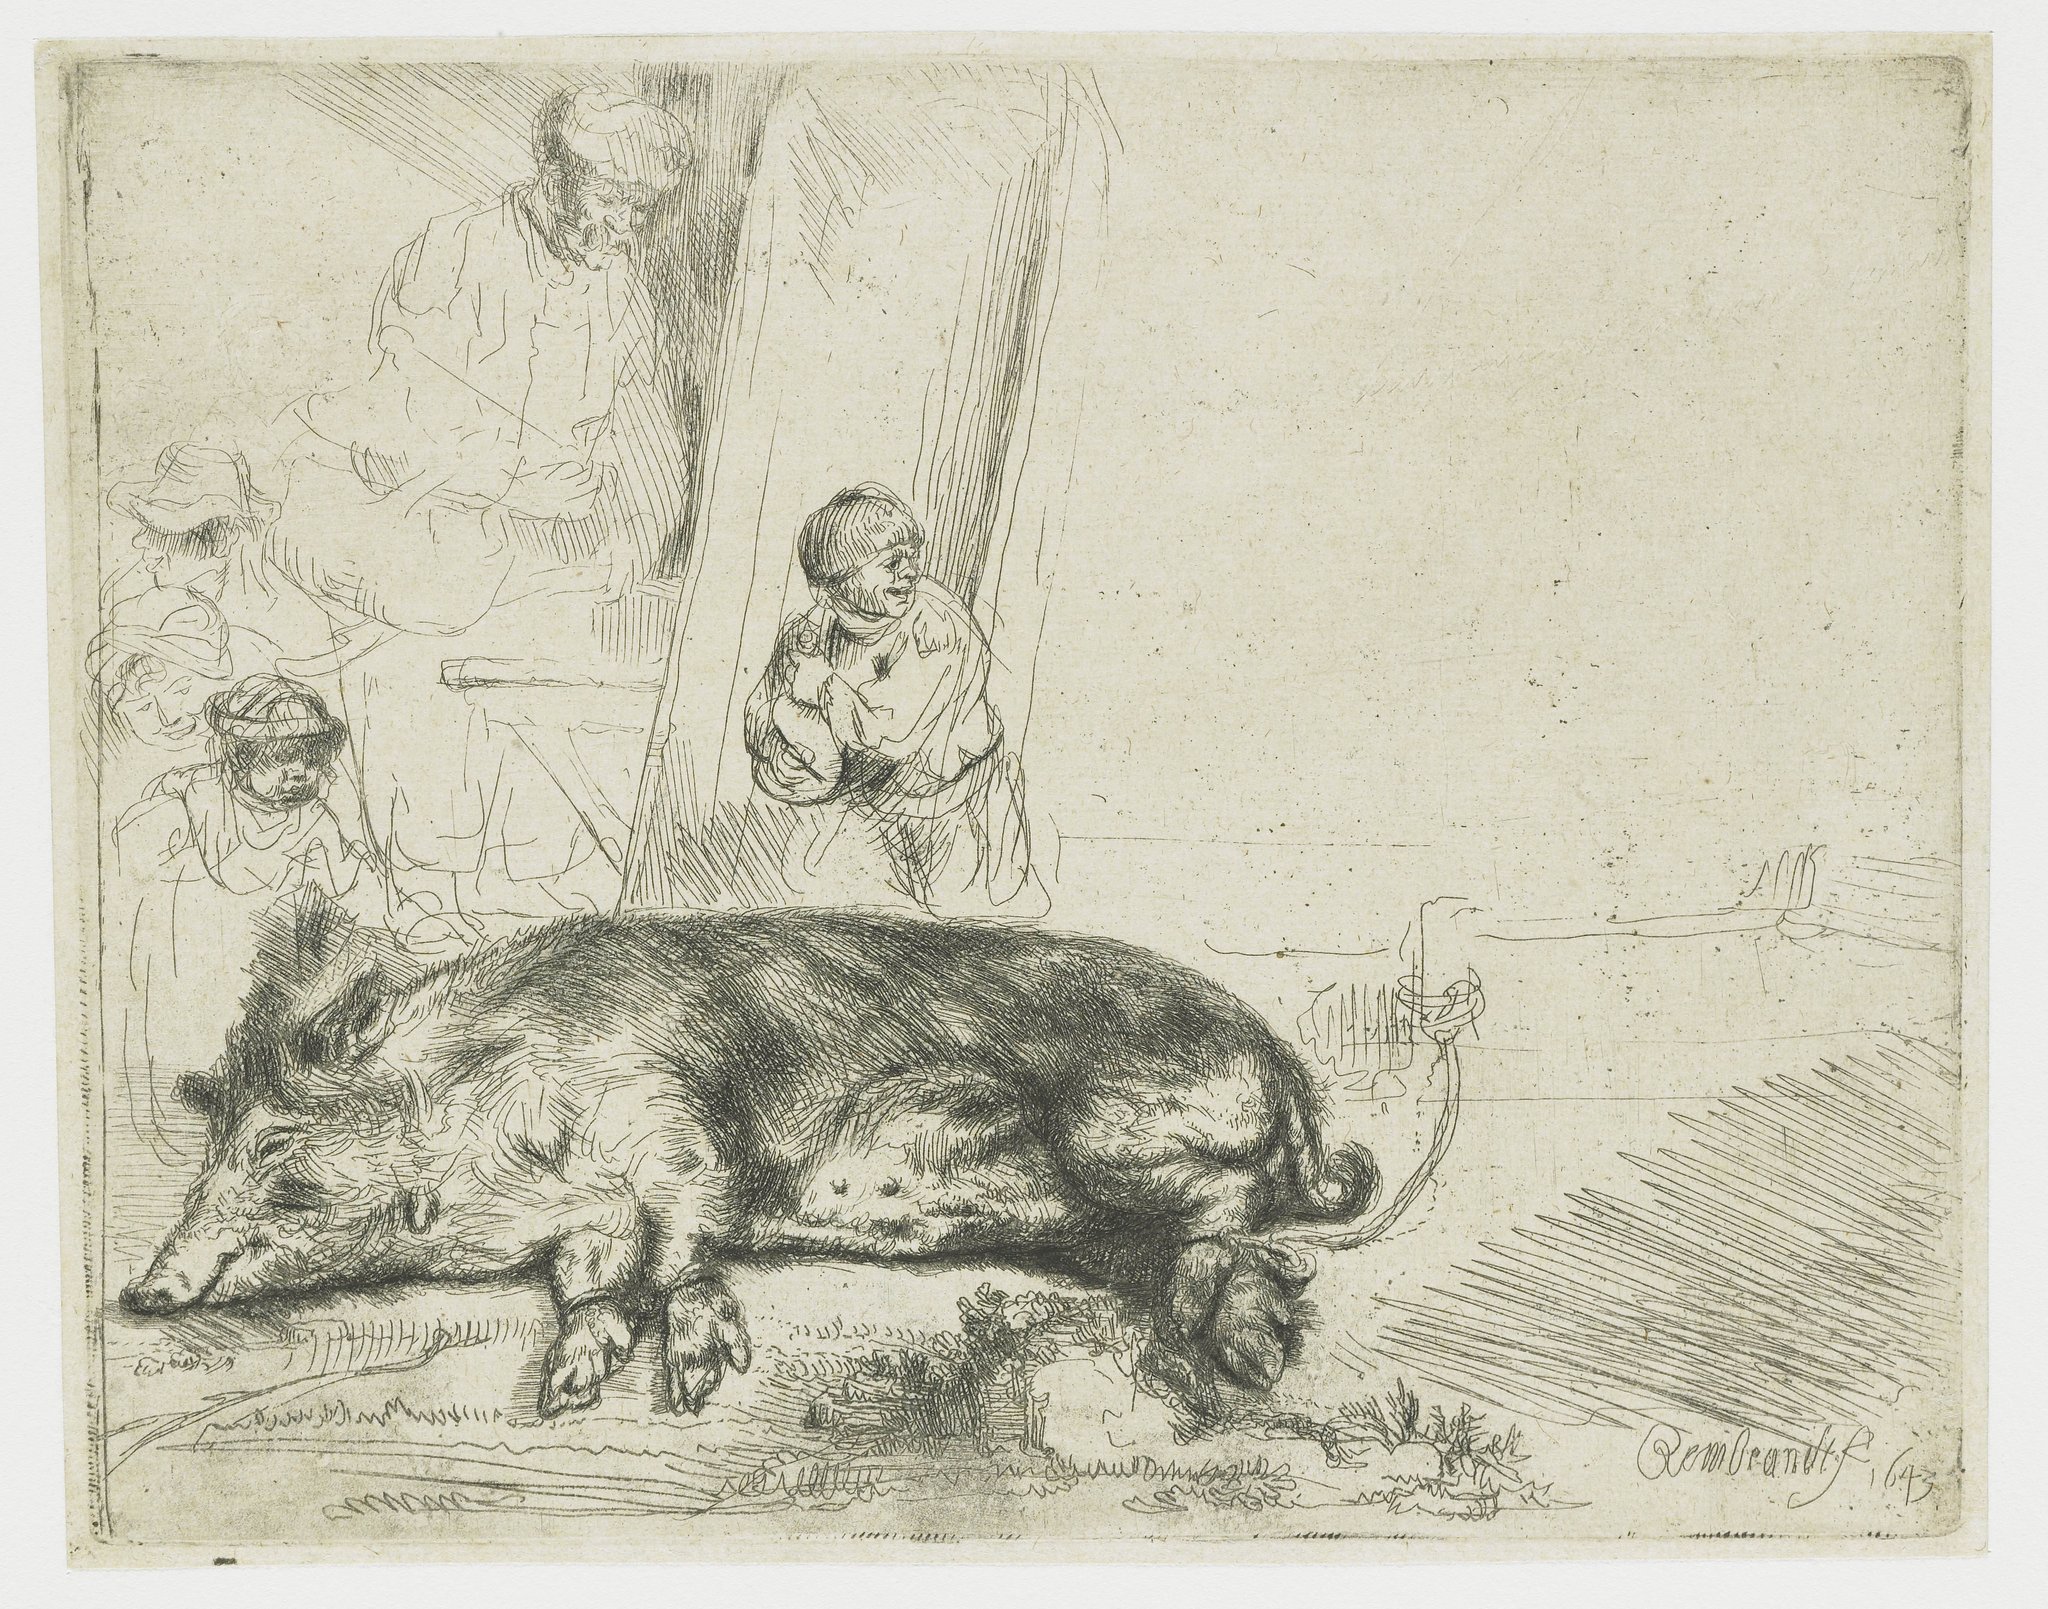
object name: print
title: The hog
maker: rembrandt van rijn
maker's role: draughtsman, painter, print maker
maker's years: 1606-1669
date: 1643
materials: paper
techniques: drypoint, etching, intaglio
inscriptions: collector's mark: Lugt 1336, collector's mark: Lugt 2228, collector's mark: Lugt 119, signature and date: ‘Rembrandt f 1643’